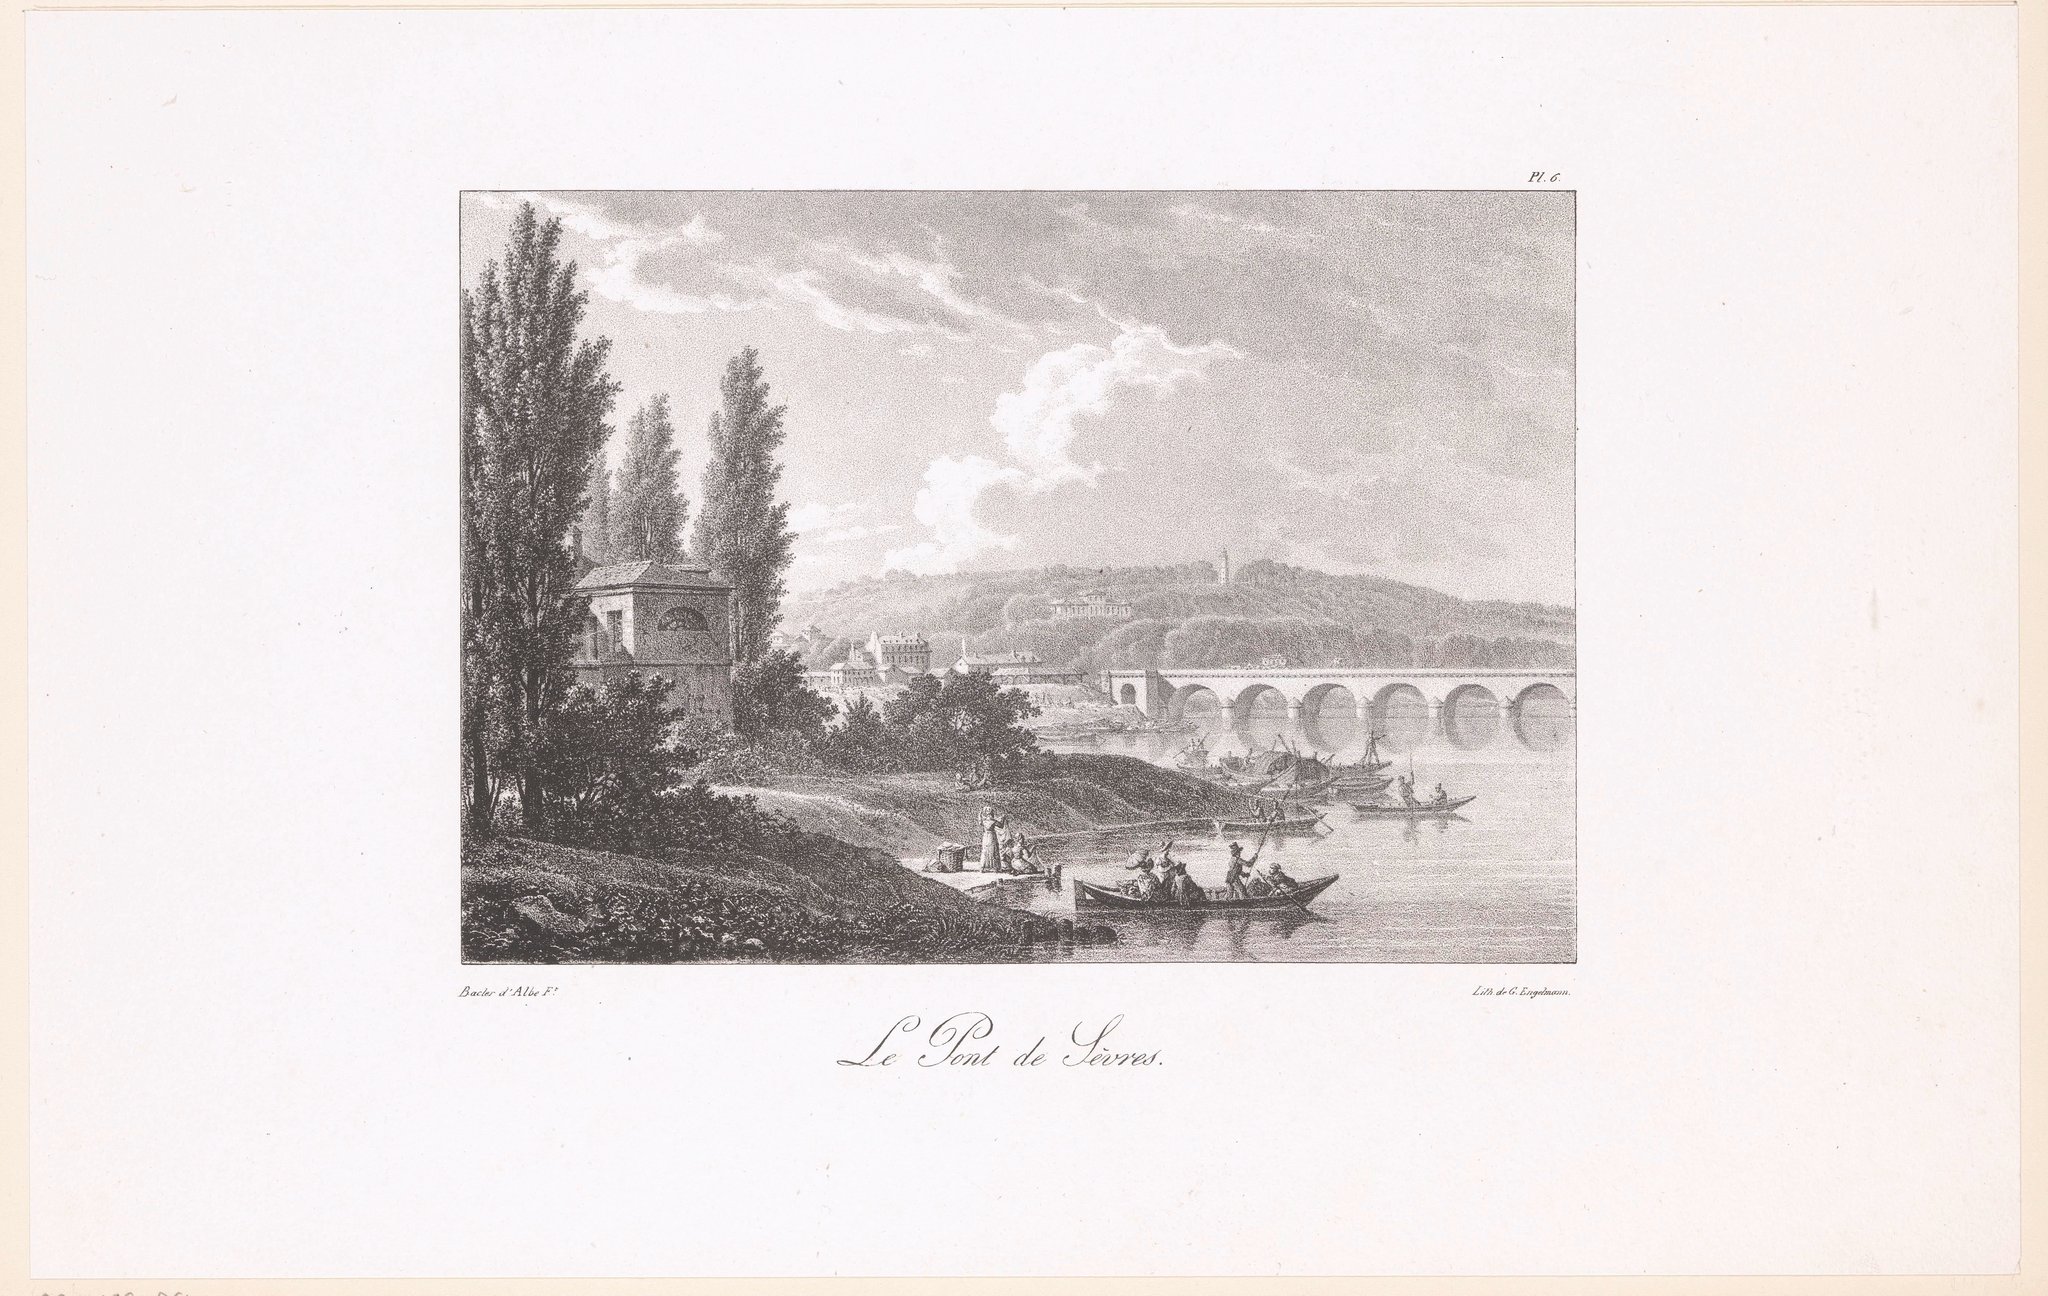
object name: print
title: Promenades pittoresques et lithographiques dans Paris et ses environs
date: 1771-1824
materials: paper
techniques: lithograph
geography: paris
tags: rowing-boat, canoe, etc., landscape with bridge, viaduct or aqueduct (+ city(-scape) with figures, staffage)